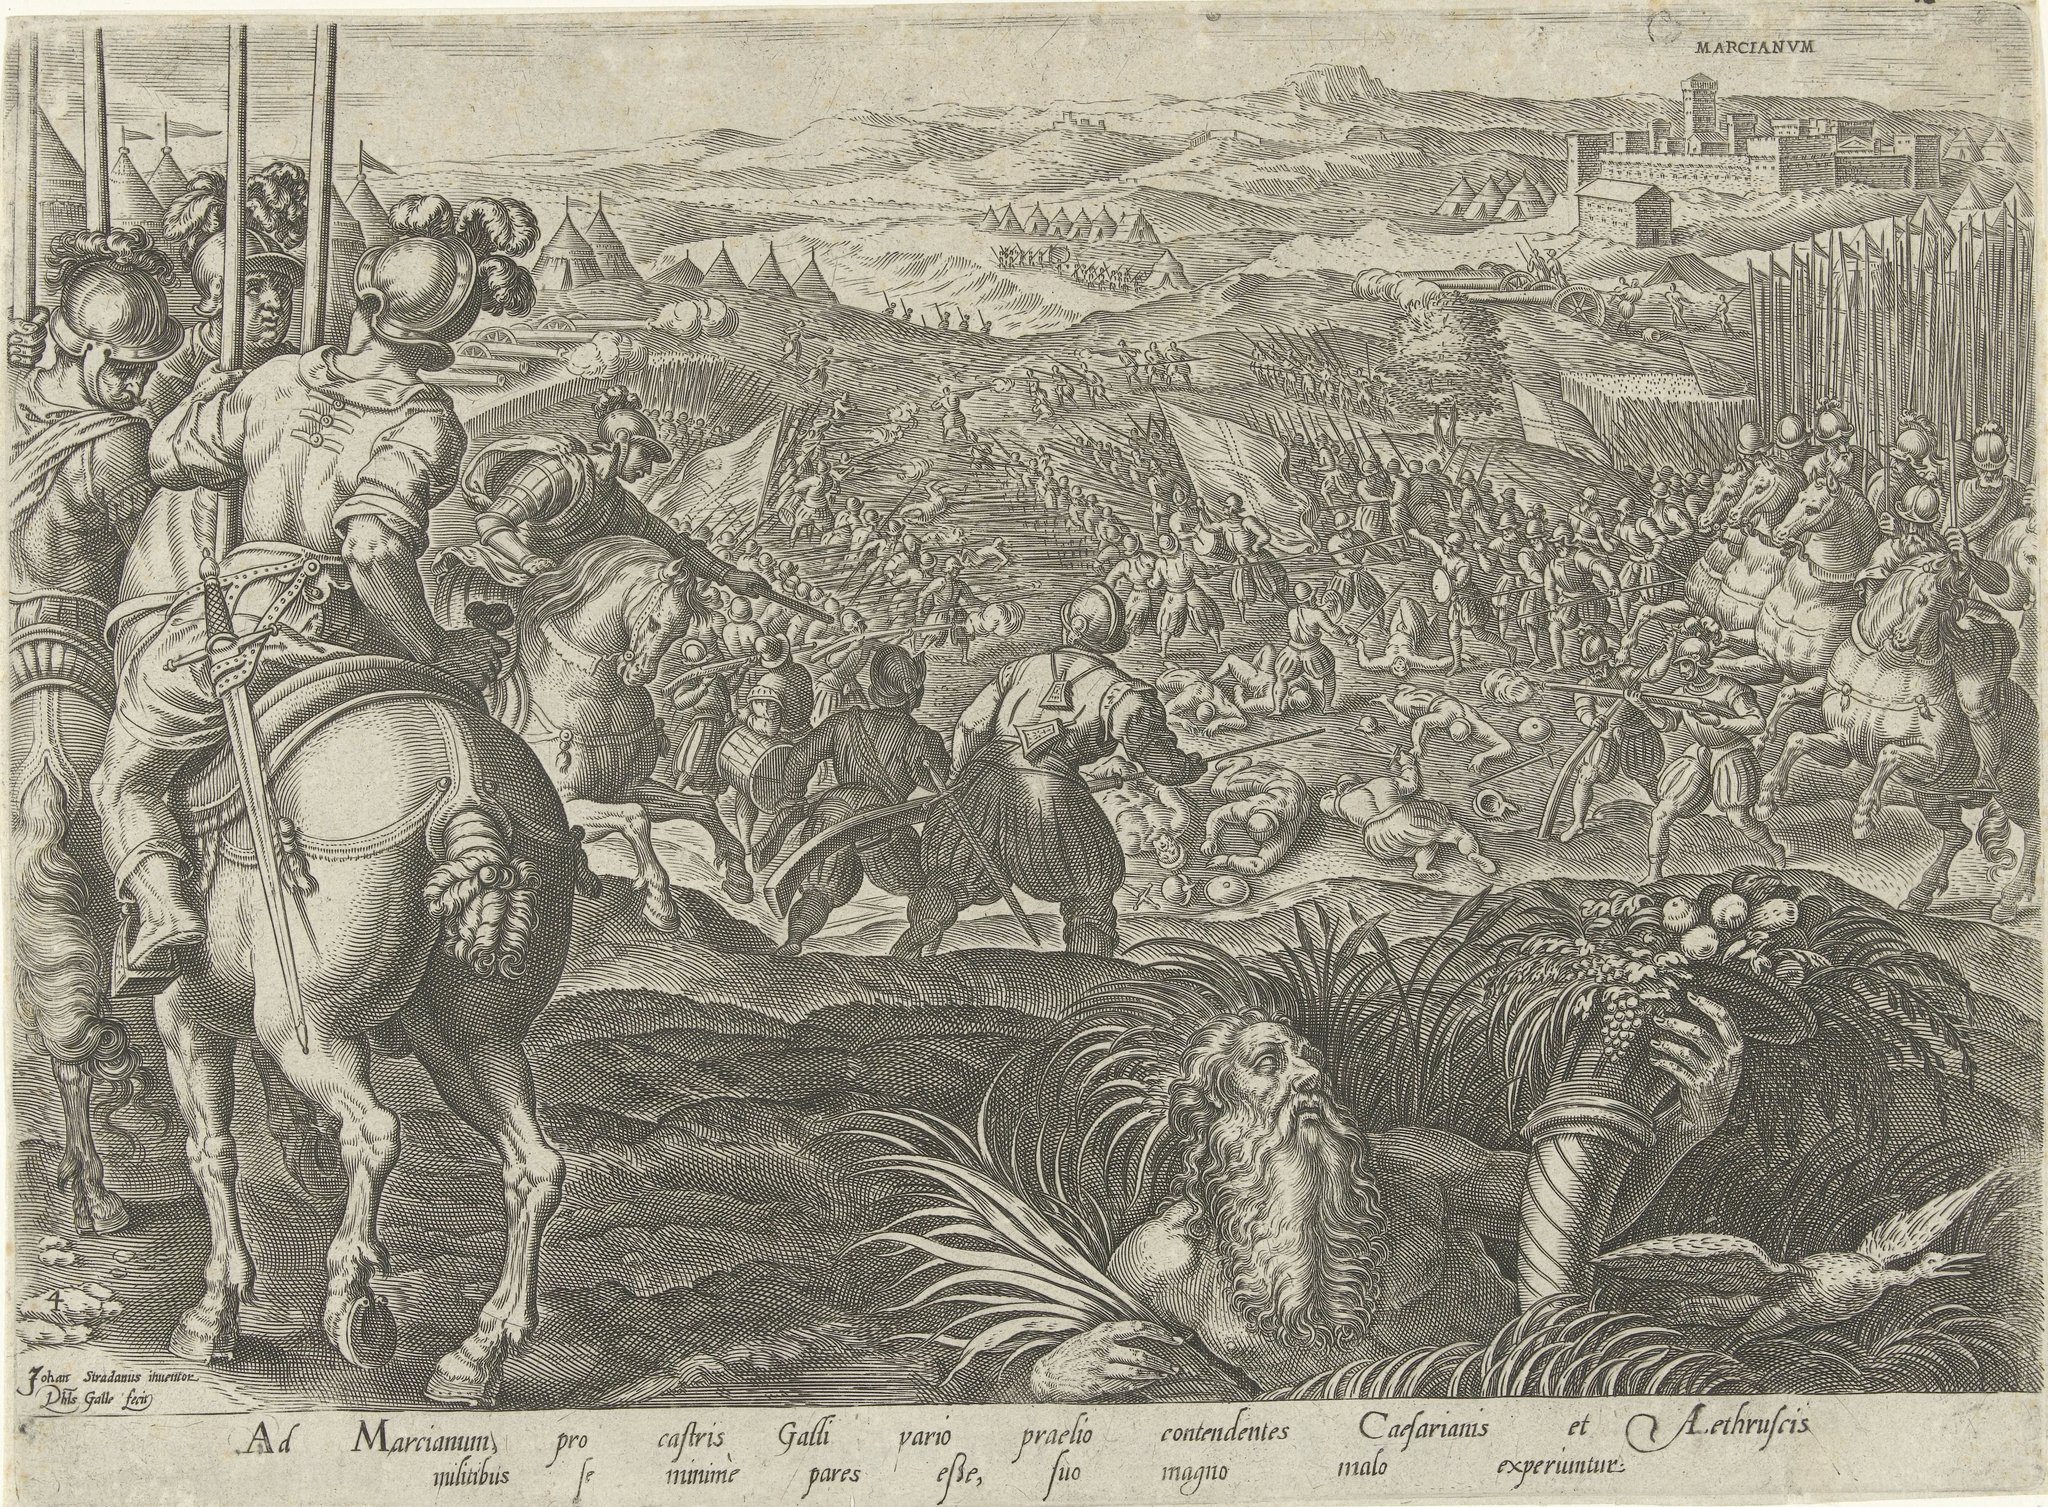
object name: history print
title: Slag bij Marciano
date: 1583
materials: paper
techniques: engraving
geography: antwerp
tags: cosimo i de' medici, pietro strozzi, 'cornucopia', horn of plenty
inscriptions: collector's mark: Lugt 2228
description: De veldslag bij Marciano in 1554. Het leger van De'Medici onder leiding van Gian Giacomo De'Medici tegenover het Franse leger van Pietro Strozzi. In de achtergrond de stad Marciano. In de voorgrond een riviergod met een cornucopia. De prent heeft een Latijns onderschrift en maakt deel uit van een serie over de familiegeschiedenis van het geslacht De' Medici.